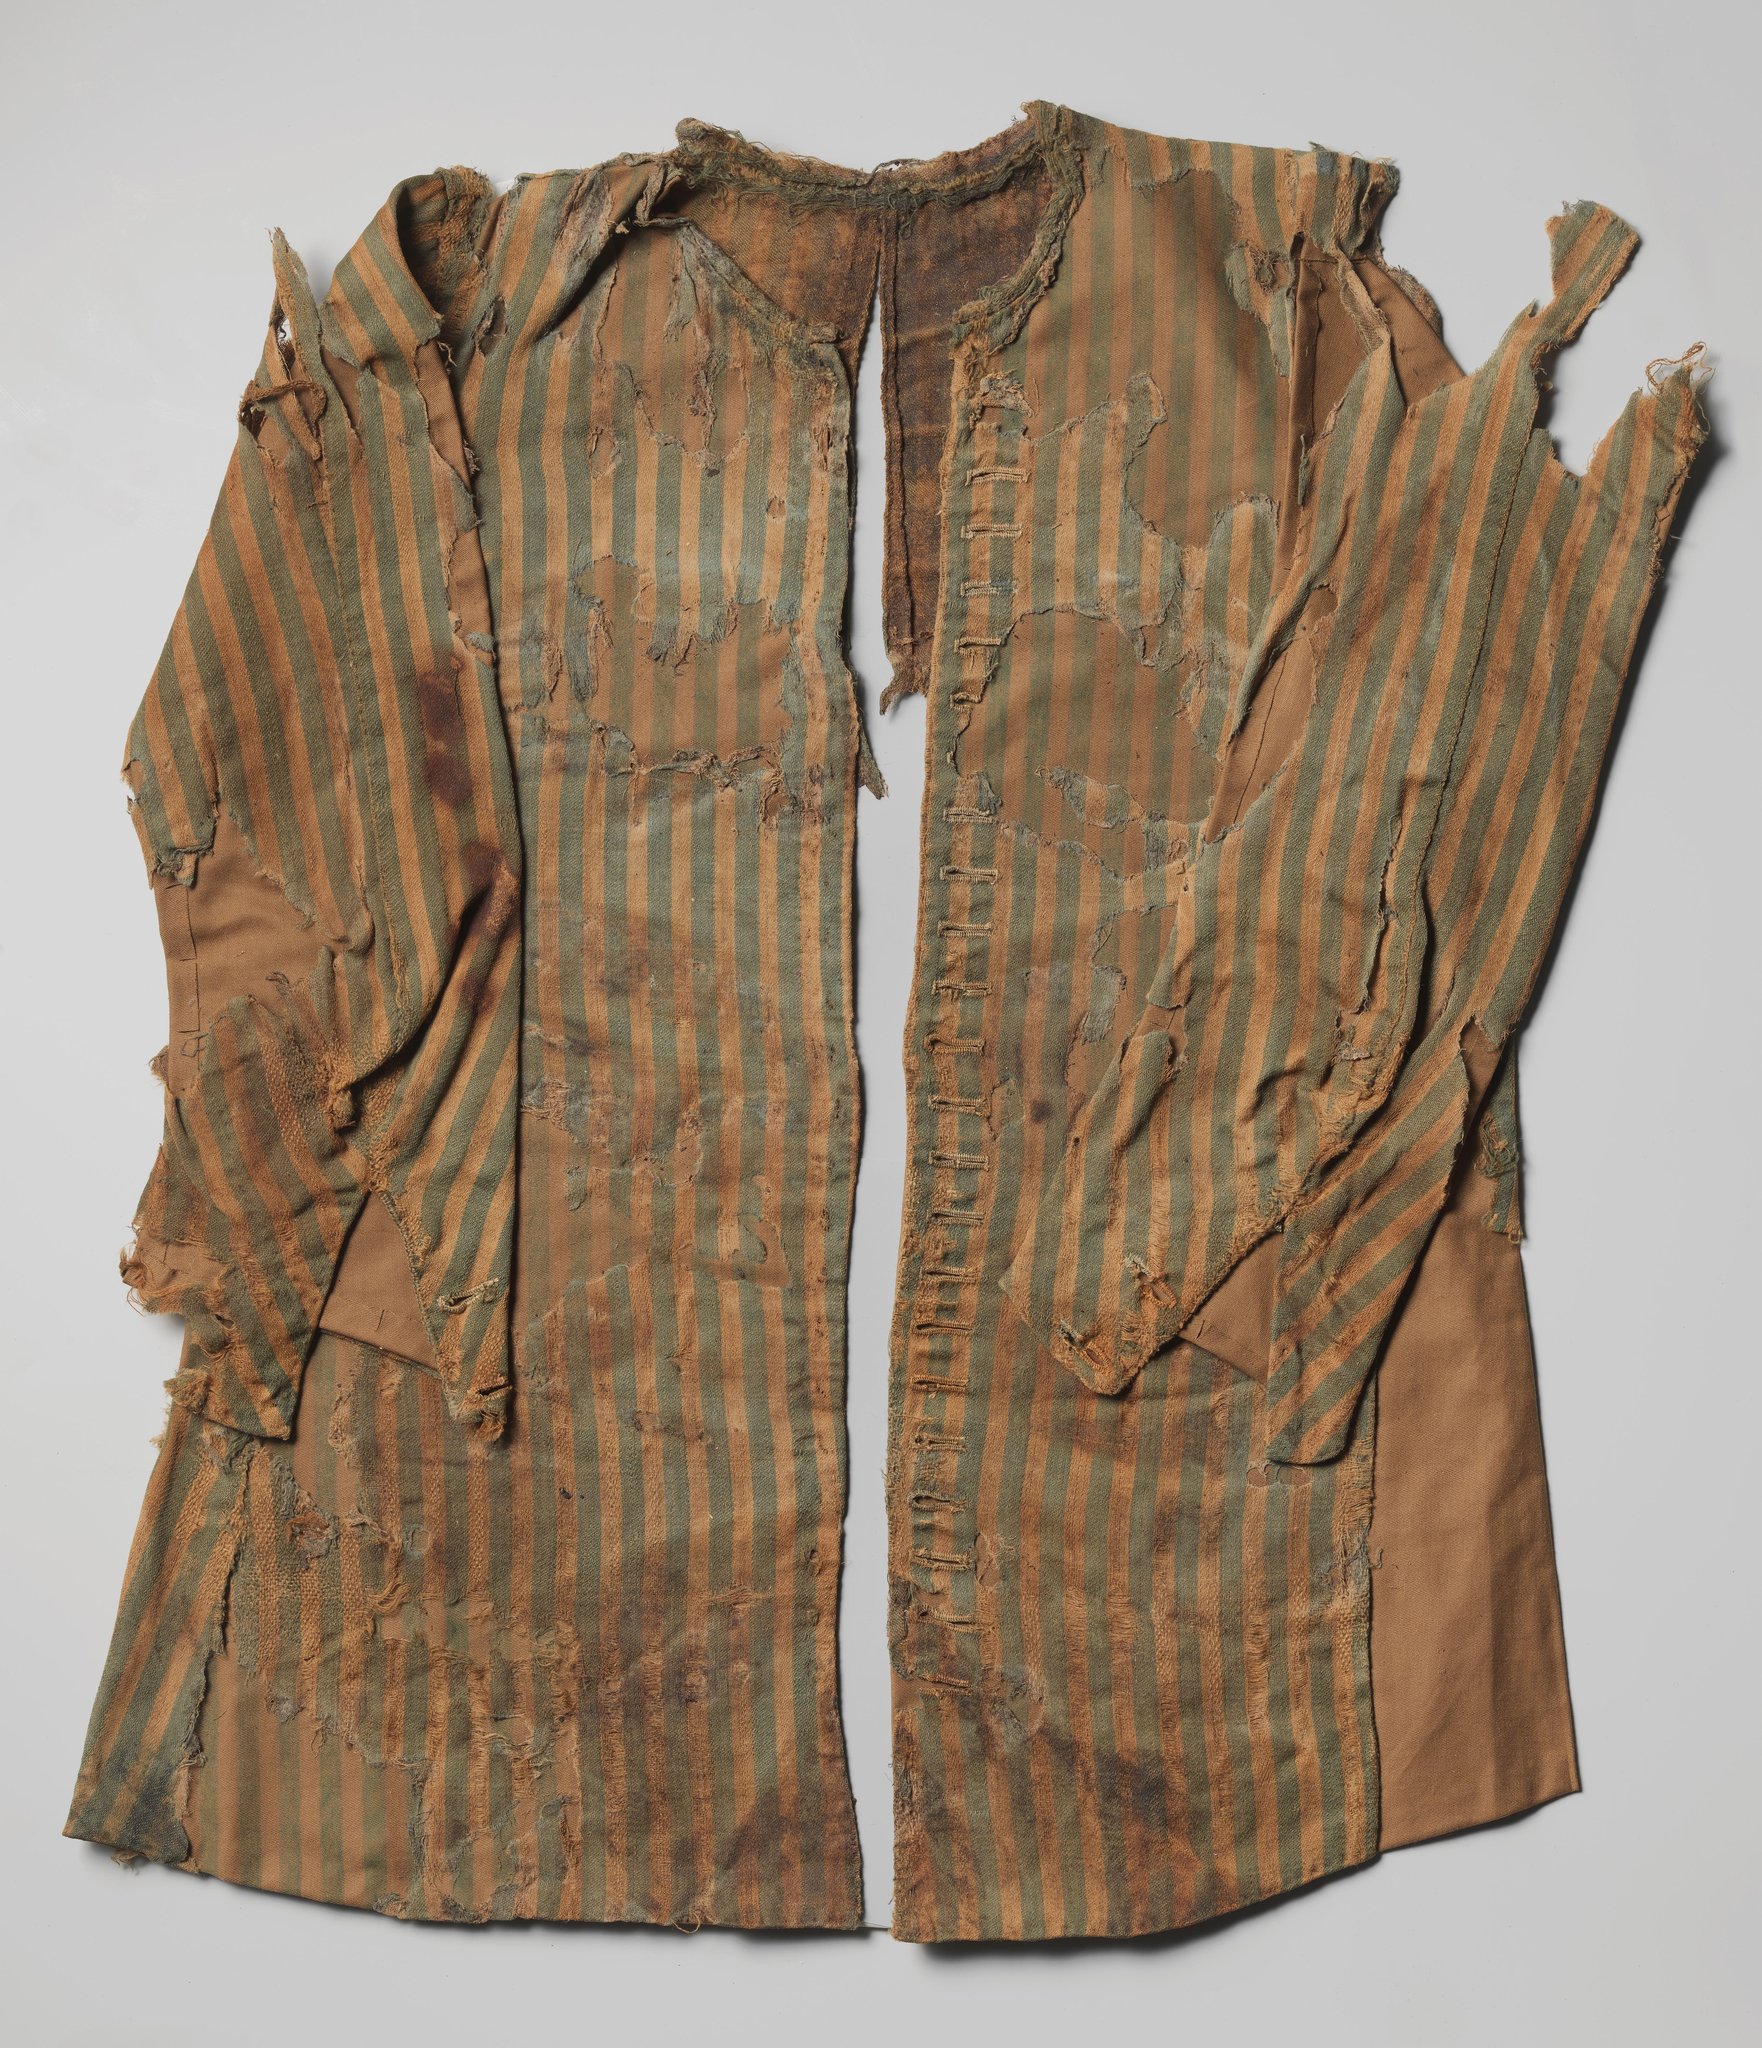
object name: coat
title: Mouw van jas, groen met wit gestreept, van dunne, soepele stof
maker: Anonymous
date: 1740-1760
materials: wool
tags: noordse compagnie, spitsbergen, zeeuwsche uytkyck, svalbard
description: Mouw van jas, groen met wit gestreept, van dunne, soepele stof. De jas was waarschijnlijk niet gevoerd. De smalle mouw werd bij de pols gesloten met twee knopen, en bestaat uit twee grote langwerpige delen en een klein reepje dat onder de oksel is ingezet. De mouw was waarschijnlijk oorspronkelijk slechts gedeeltelijk aan het lijf genaaid. De 0,85 cm brede lengtestrepen zijn gevormd door afwisselend groepen van lichtbruine (oorspronkelijk witte?) en van groene kettingdraden. Het lichtbruine inslaggaren is door de wijze van weven grotendeels bedekt door de kettinggarens. Geweven in satijnbinding.